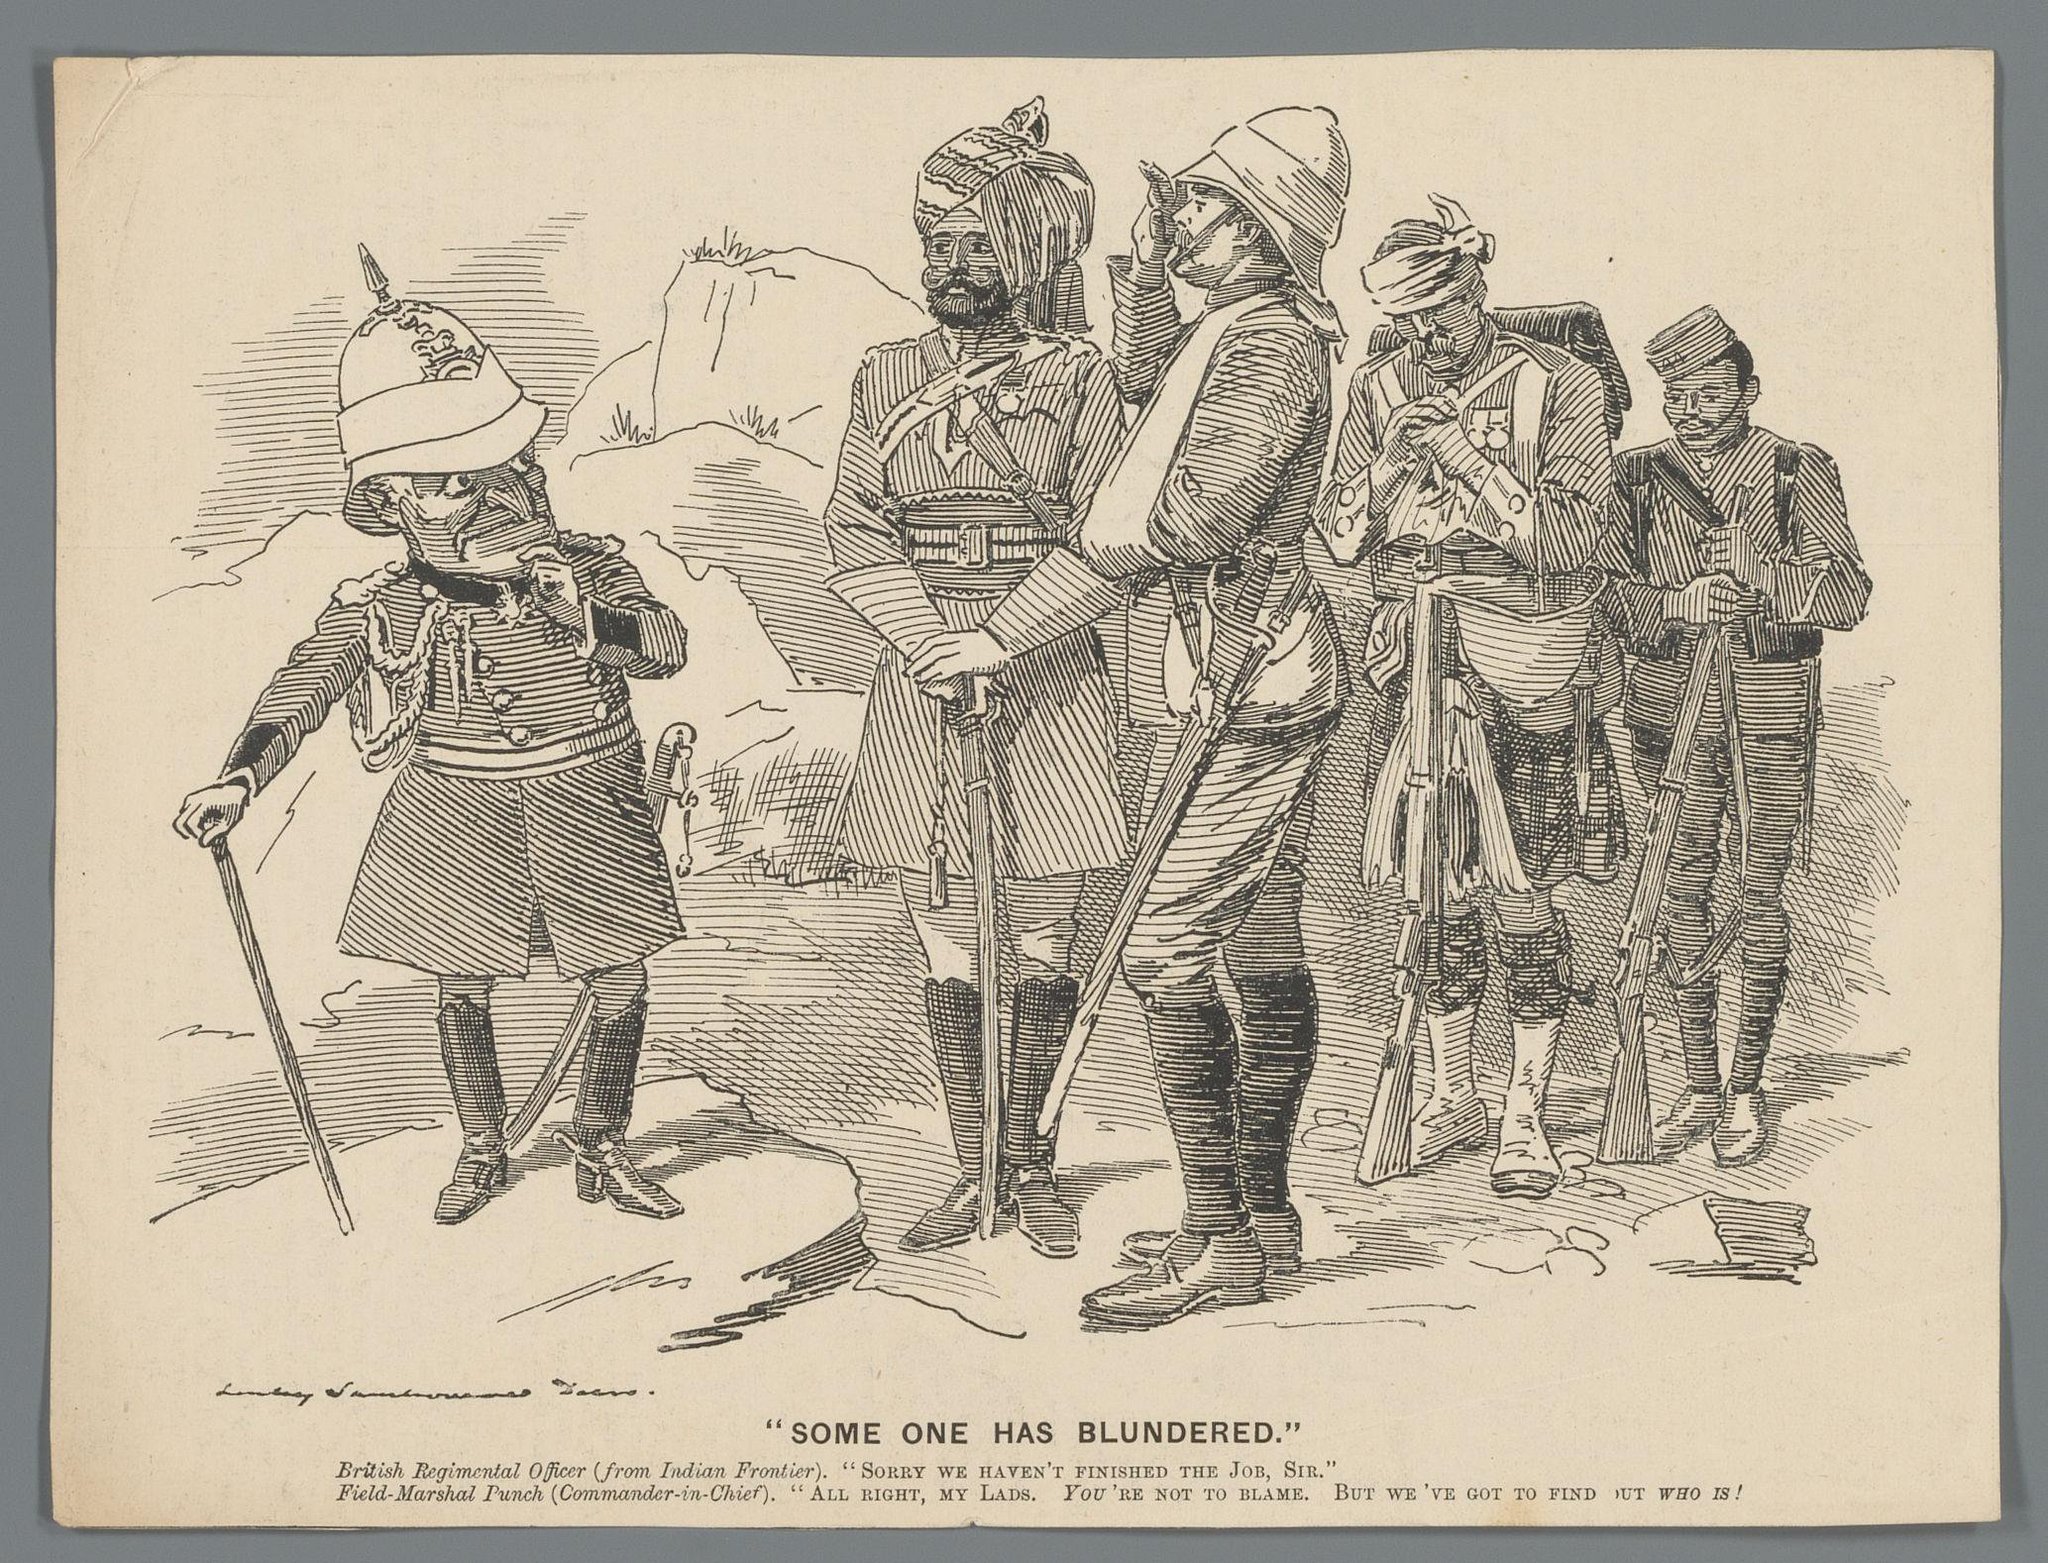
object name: cartoon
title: "Some one has blundered."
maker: edward linley sambourne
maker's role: draughtsman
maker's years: 1844-1910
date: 1890-1904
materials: paper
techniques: line block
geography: england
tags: medical aid and nursing of the sick and wounded, after the battle, political caricatures and satires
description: Veldmaarschalk Punch spreekt met gewonde Britse soldaten in India. Spotprent uit het Engelse satirische tijdschrift Punch.